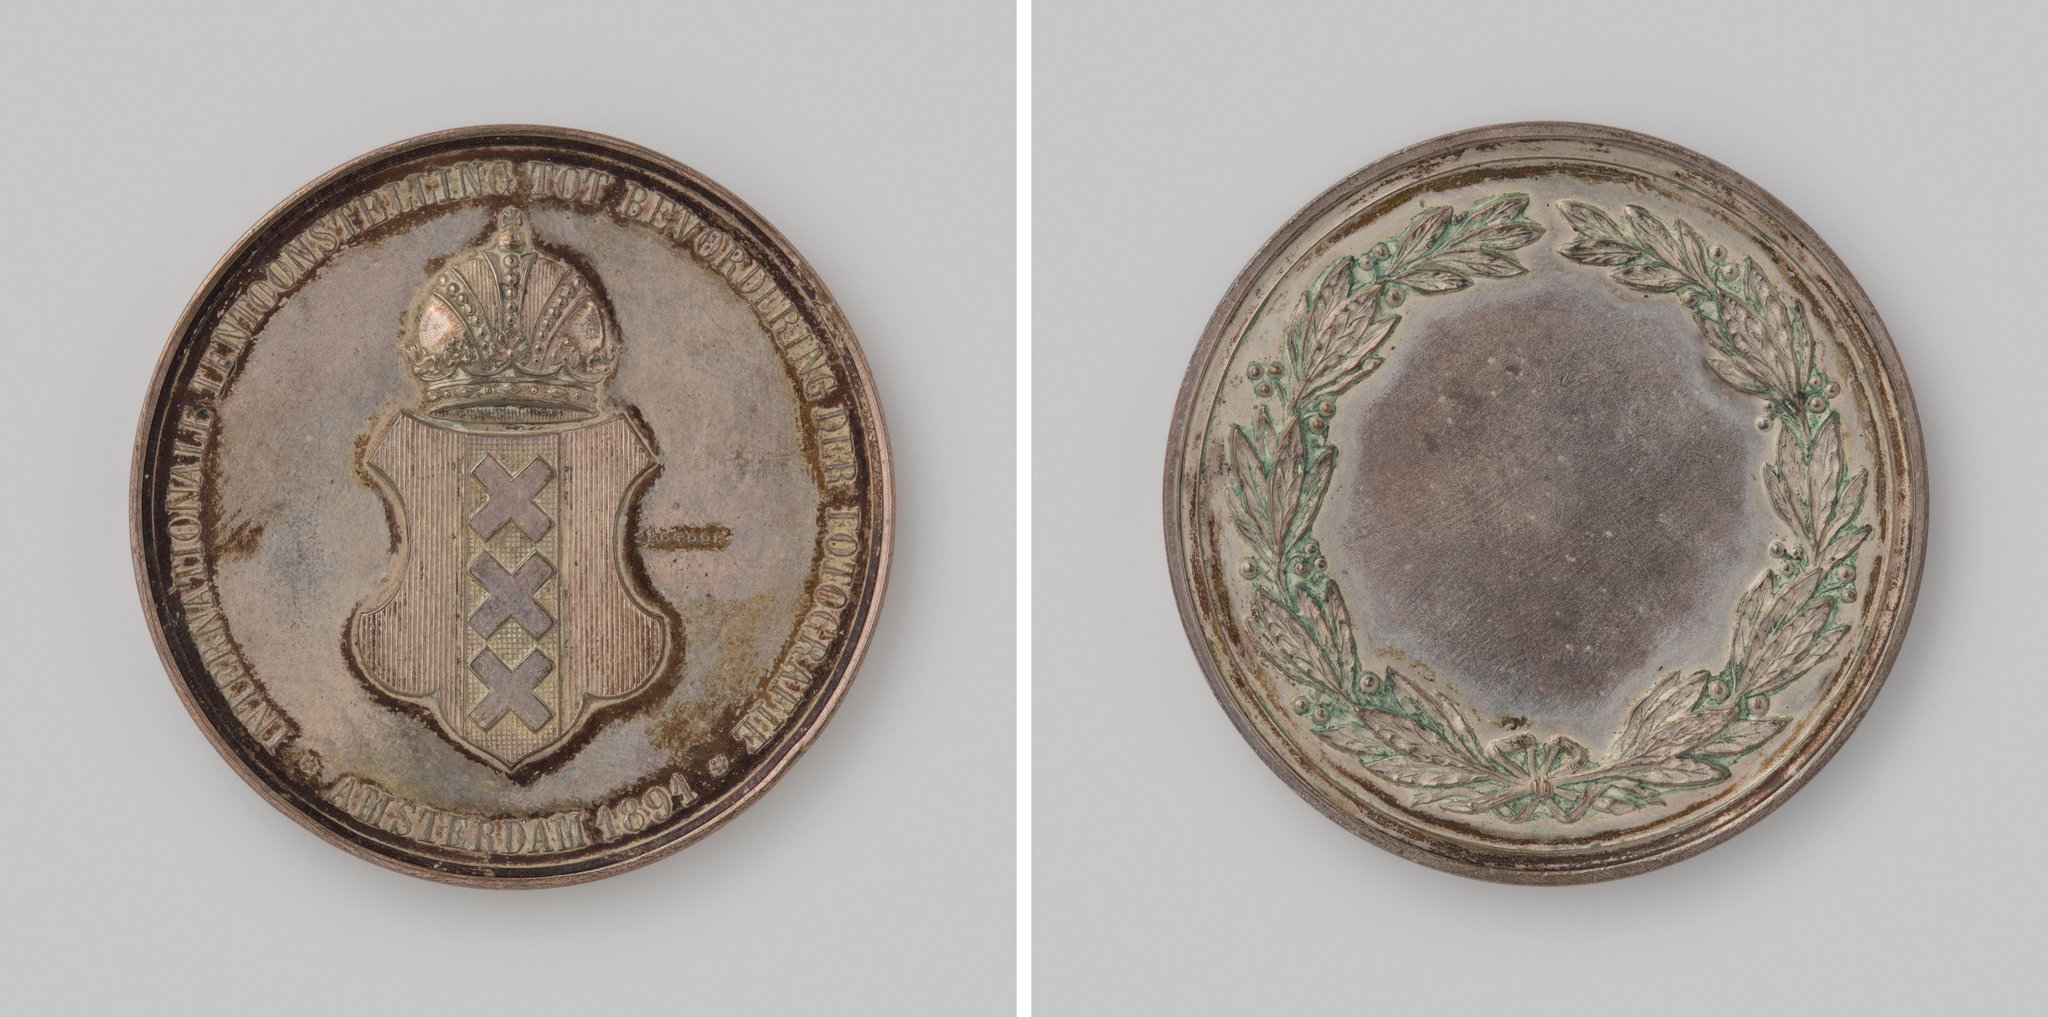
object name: medal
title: Internationale tentoonstelling tot bevordering der fotografie Amsterdam 1891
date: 1891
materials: silver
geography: utrecht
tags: coat of arms (as symbol of the state, etc.) (+ city; municipal)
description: Penning van zilver. Voorzijde penning: gekroond wapenschild (wapen van Amsterdam), met omschrift; keerzijde: leeg veld (ruimte voor de naam van een winnaar) binnen lauwerkrans. Met bijbehorende doos (NG-2014-22-2).